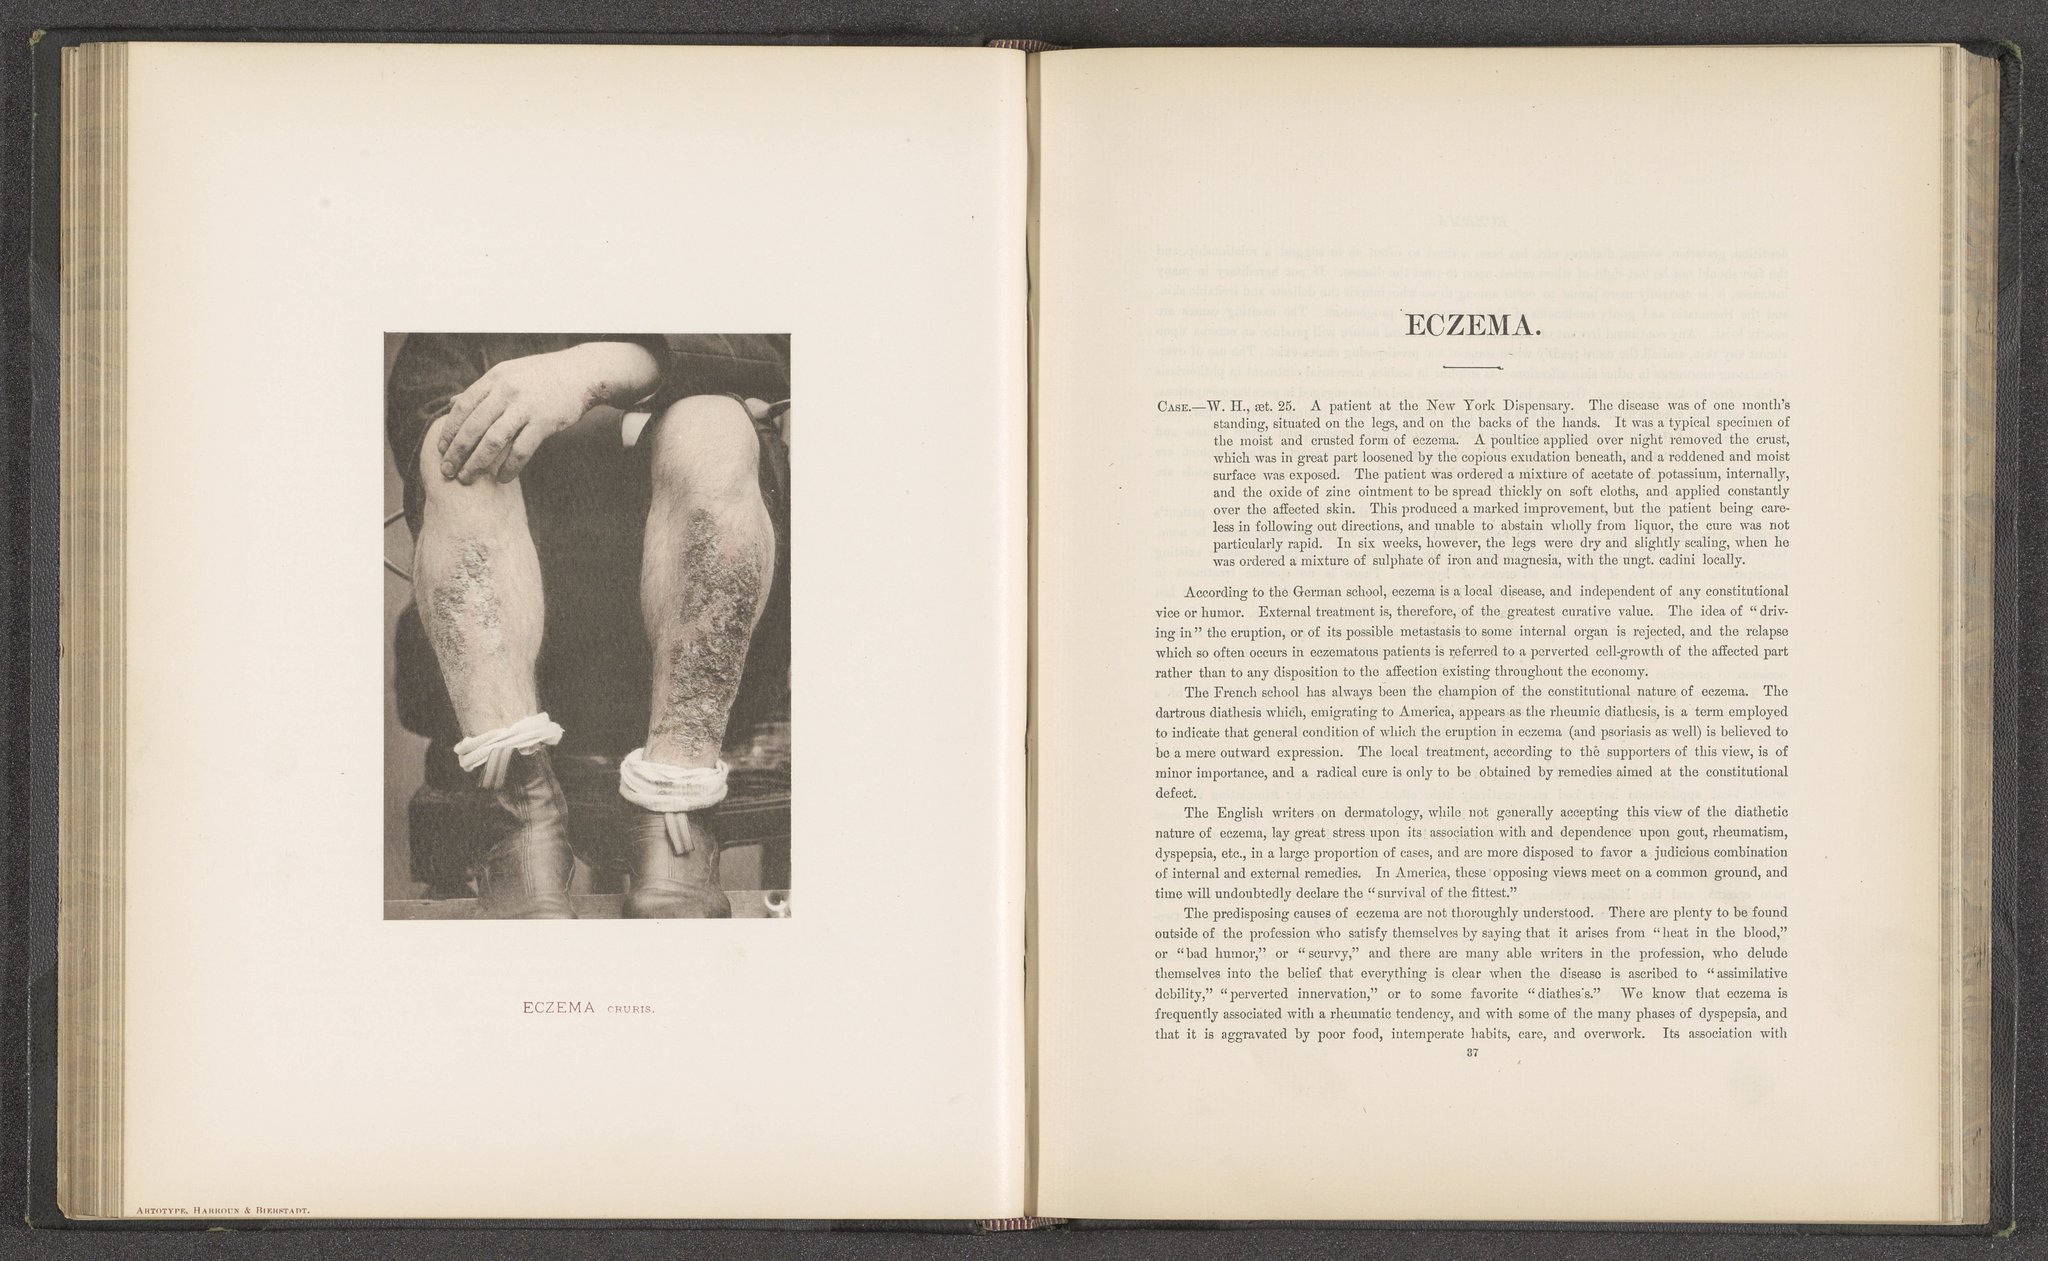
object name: page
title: Eczema cruris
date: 1870-1881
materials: paper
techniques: photograph, hand coloring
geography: new york city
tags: skin and venereal diseases, adult man